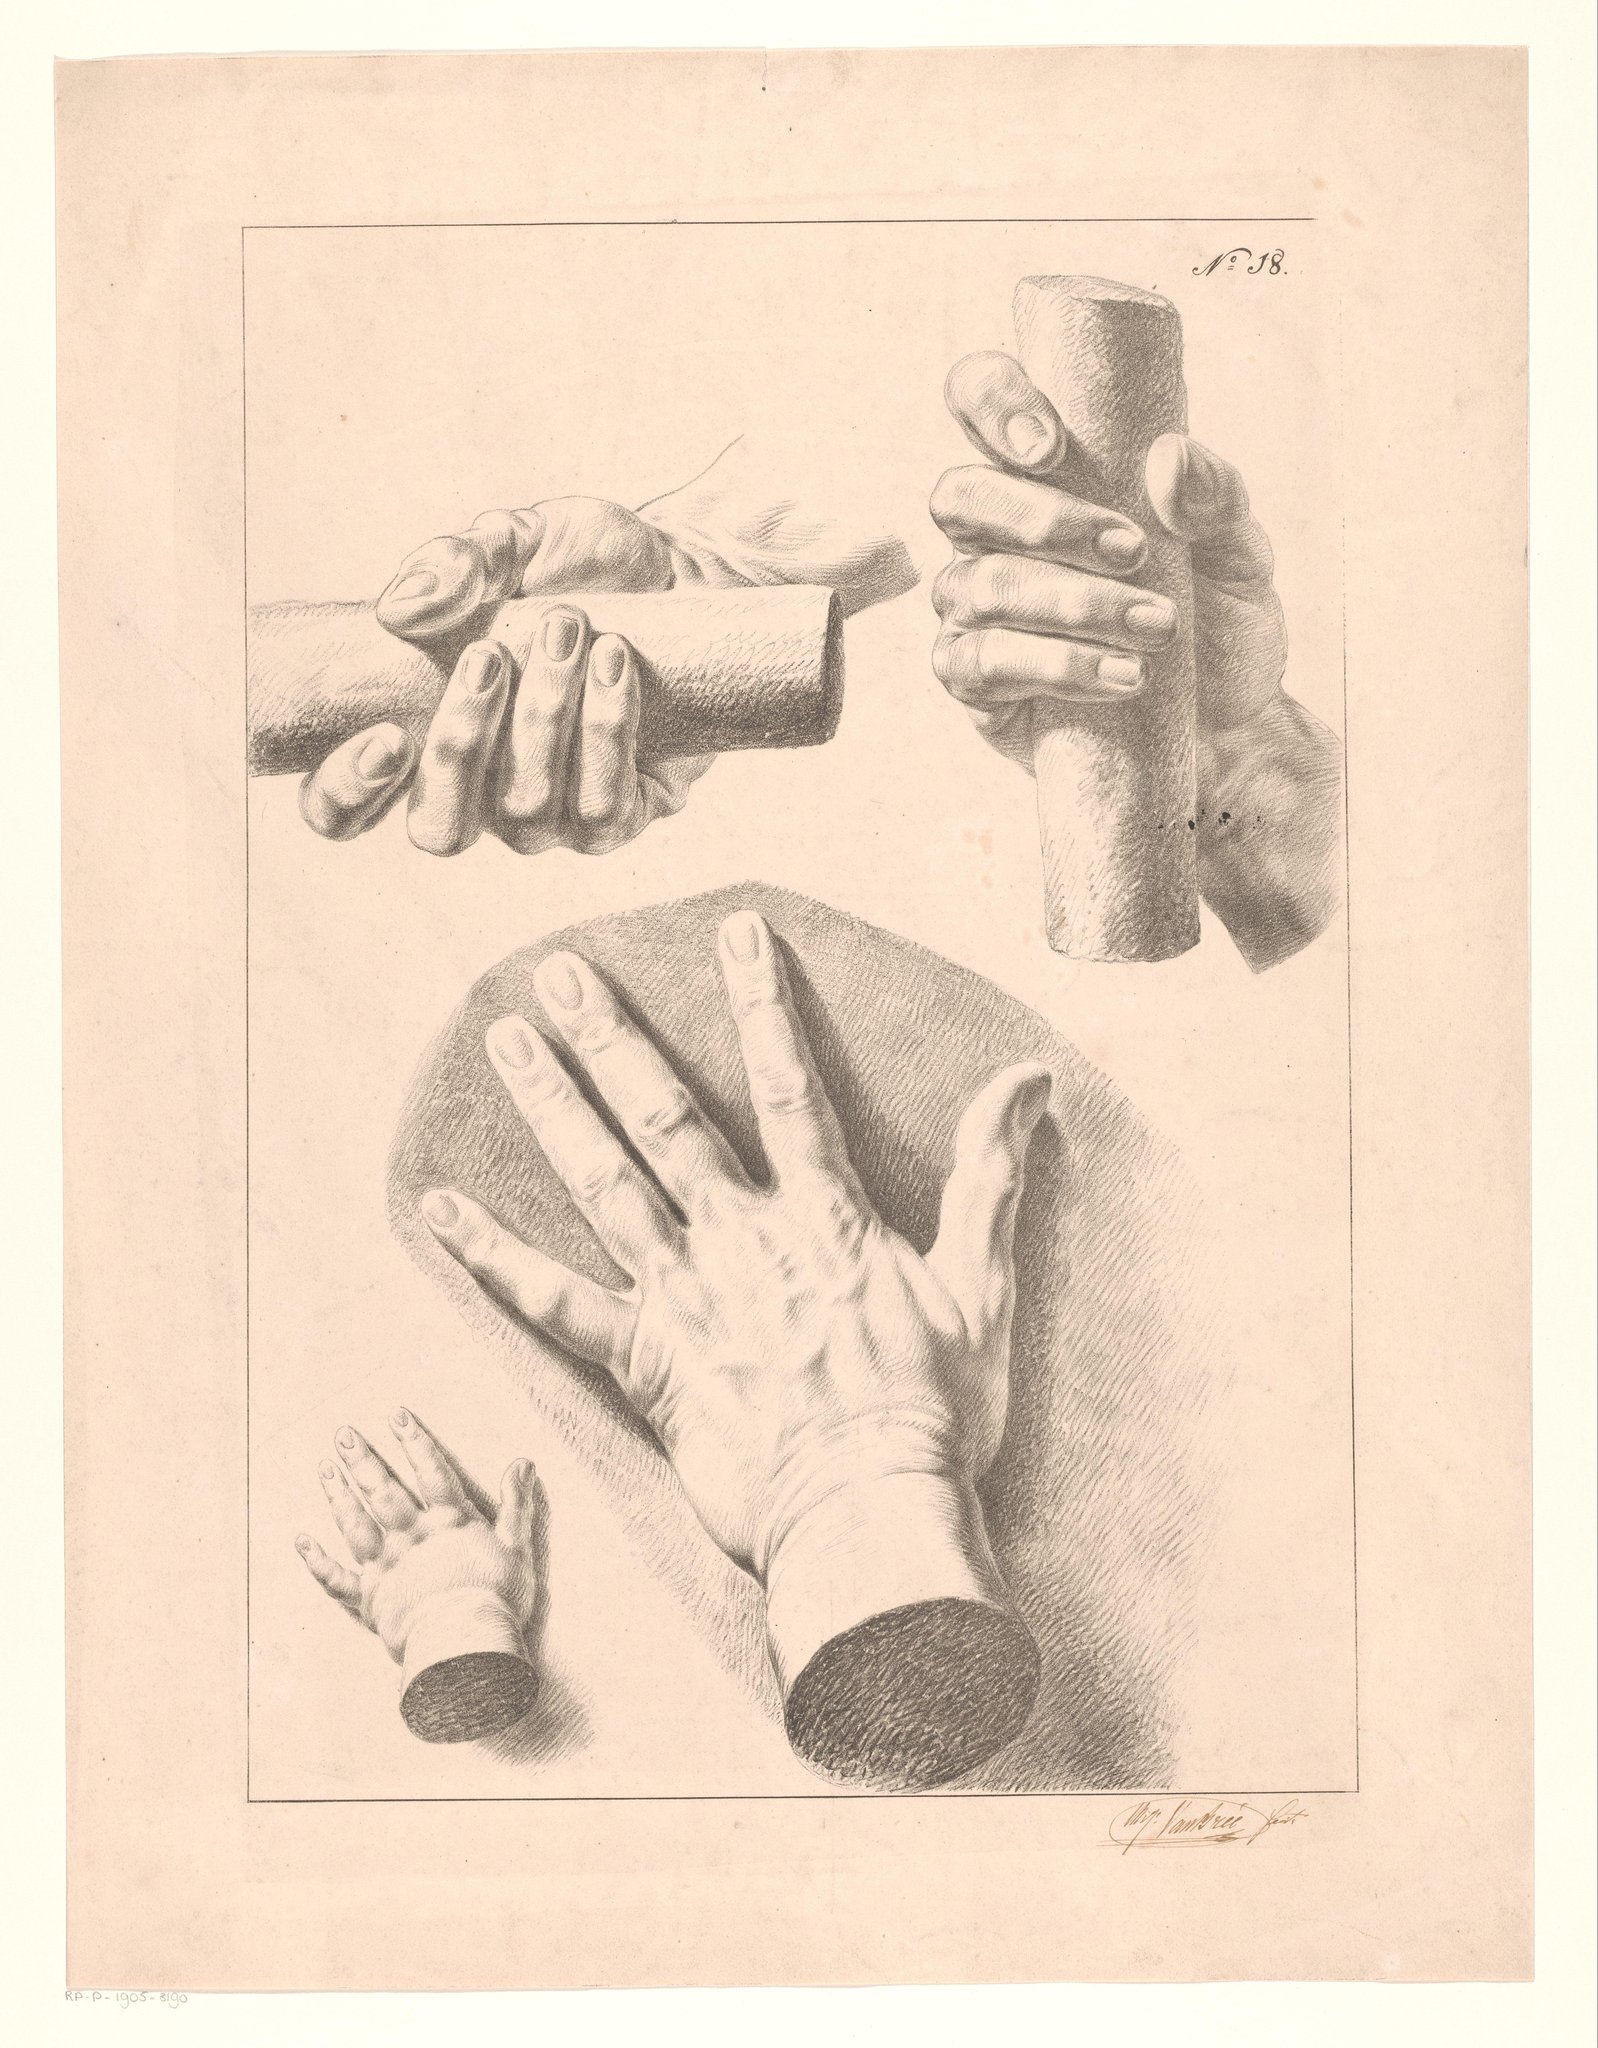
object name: print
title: Studies naar klassieke beelden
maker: mattheus ignatius van bree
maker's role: draughtsman, print maker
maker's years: 1773-1839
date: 1809-1839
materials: paper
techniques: lithograph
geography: antwerp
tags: hand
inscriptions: collector's mark: Lugt 2228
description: Twee handen met een cilinder en bovenaanzichten van een mannen- en een kinderhand.